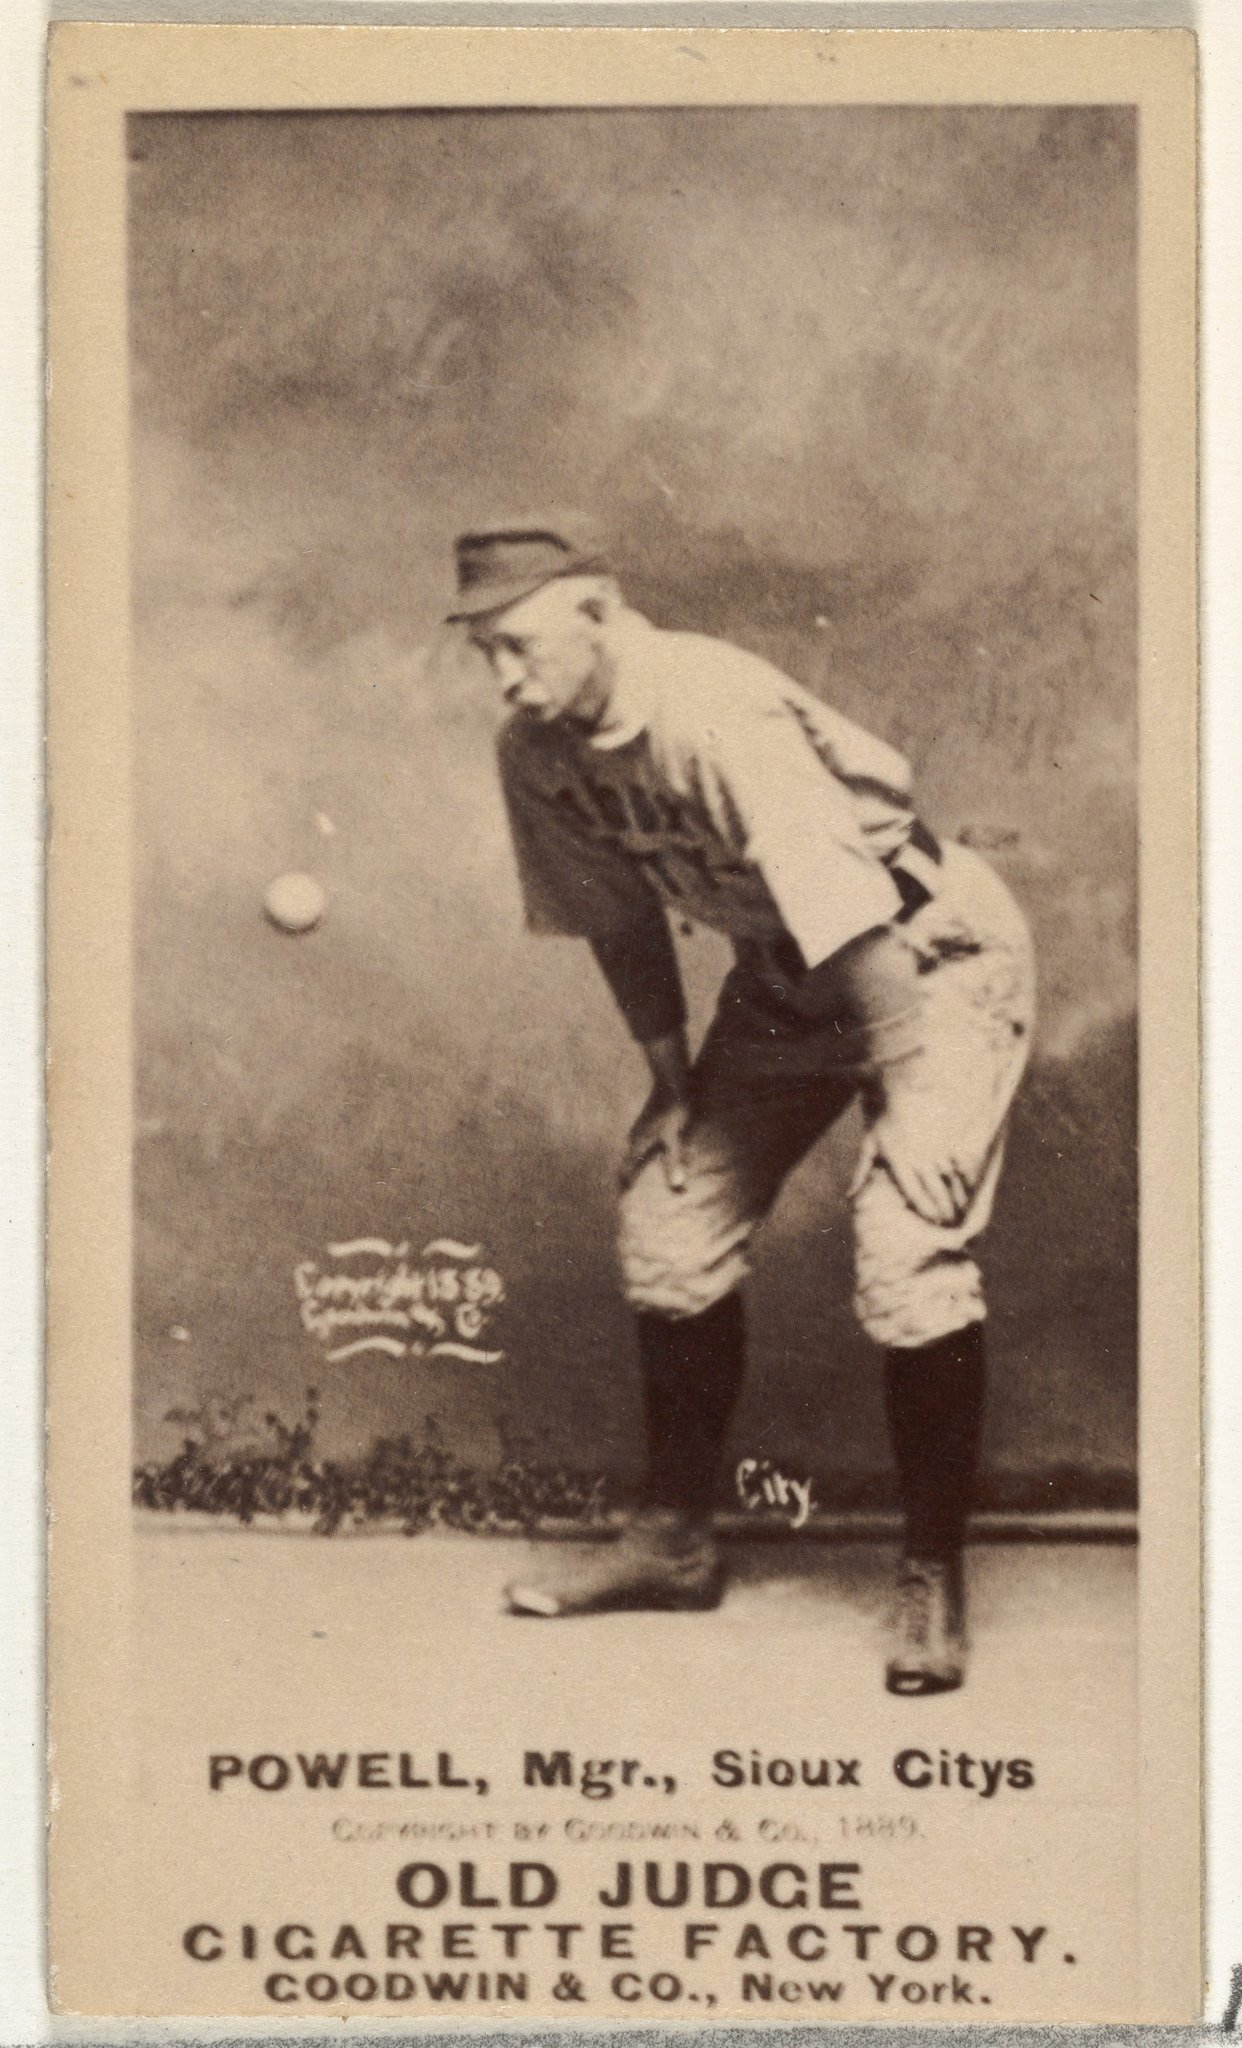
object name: baseball card, photograph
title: James Edwin "Jim" Powell, Manager and 1st Base, Sioux City Corn Huskers, from the Old Judge series (N172) for Old Judge Cigarettes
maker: goodwin & company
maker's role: publisher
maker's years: 1850-1950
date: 1889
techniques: albumen silver print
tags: men,portraits,baseball,athletes